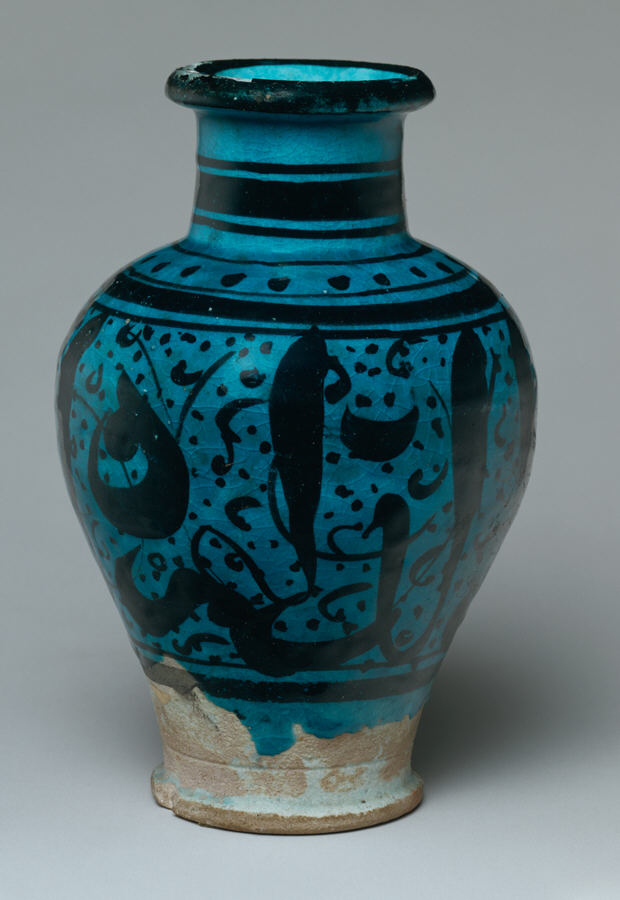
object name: jar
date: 1167-1233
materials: glaze, stonepaste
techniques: painting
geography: syria